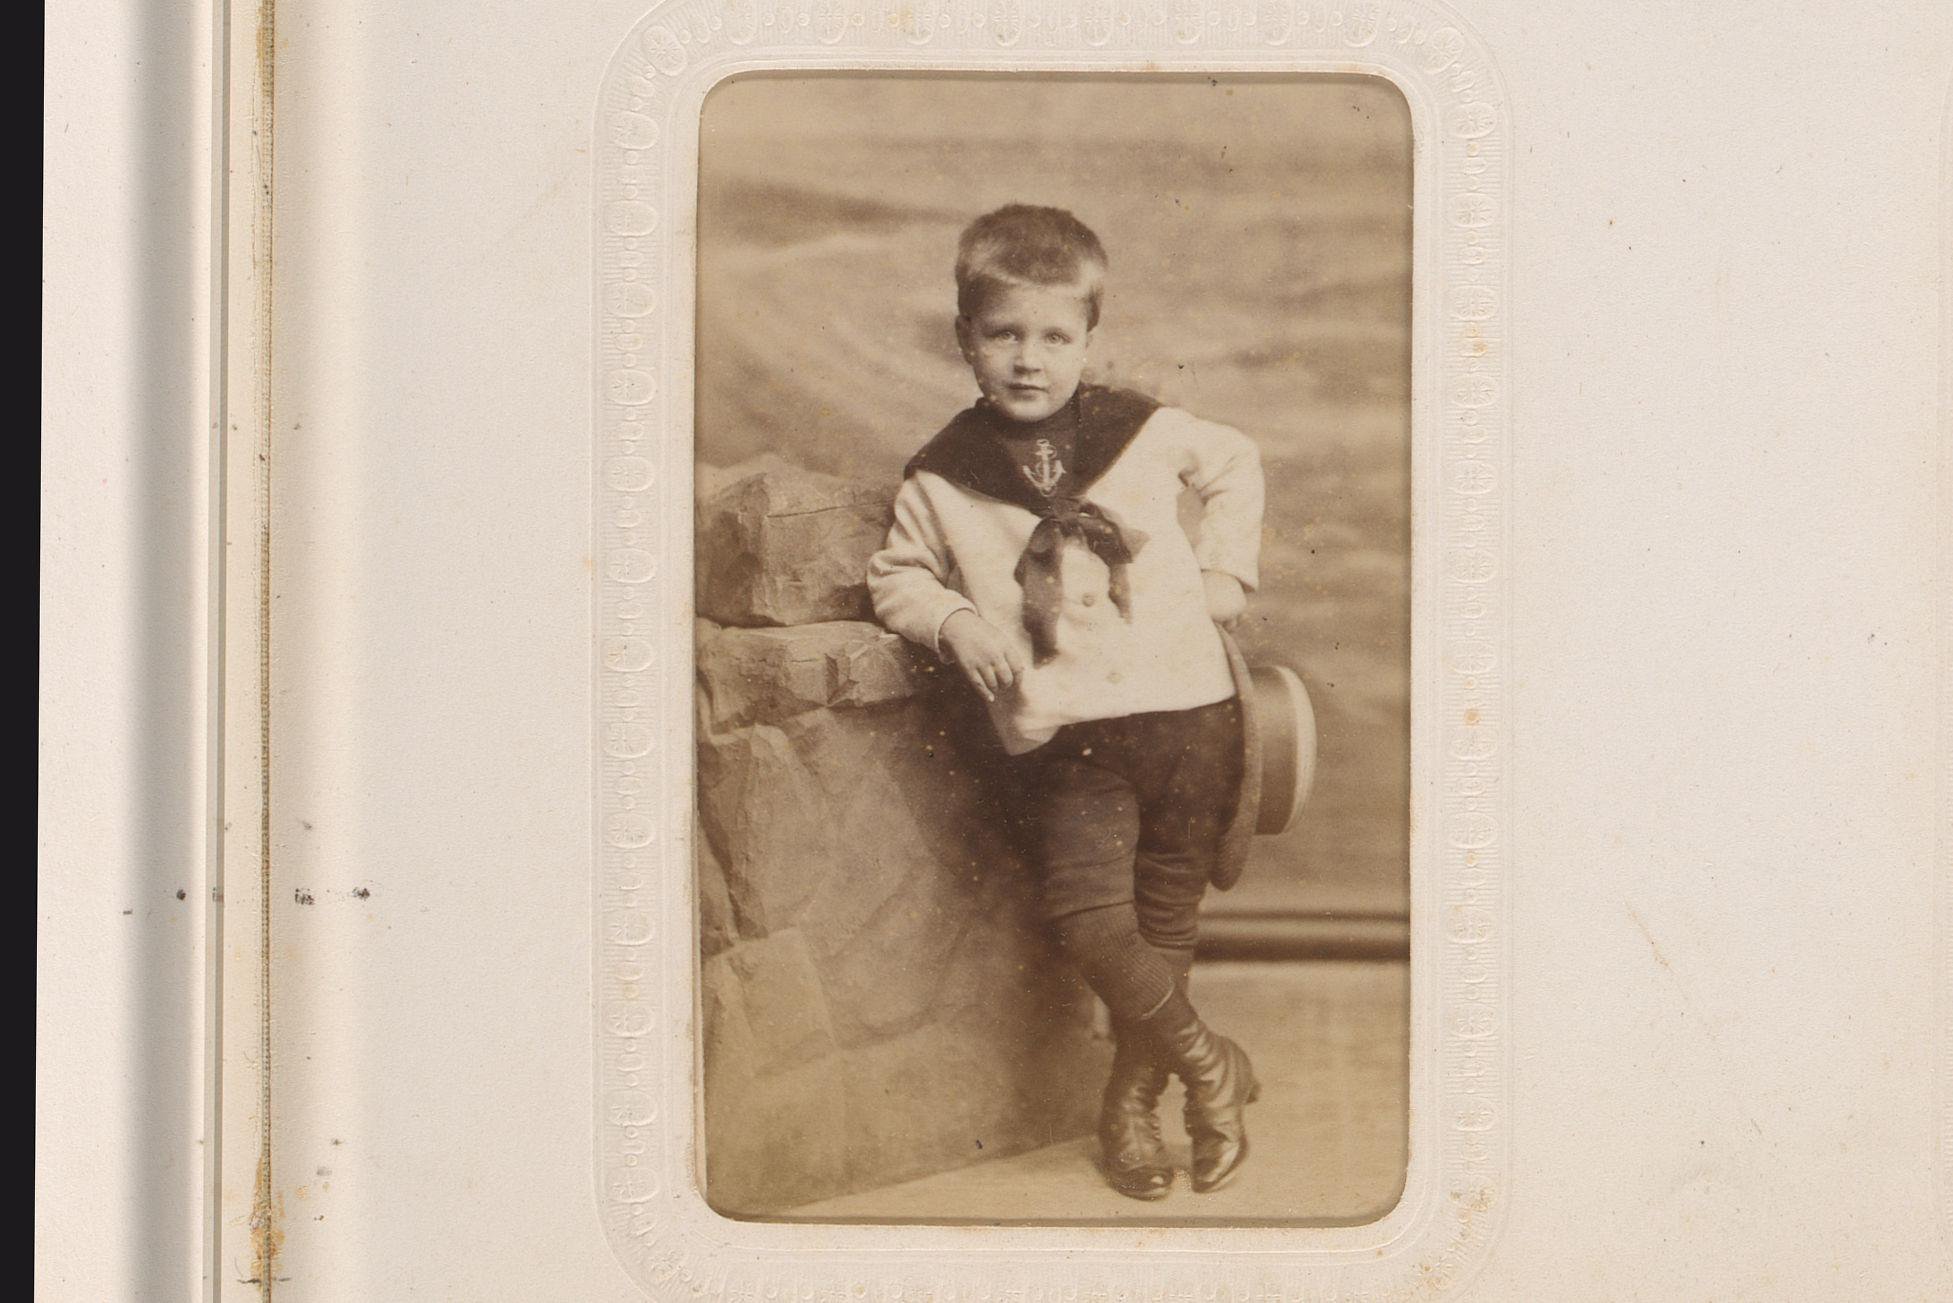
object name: photograph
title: Portret van twee kinderen op en naast een stoel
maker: Anonymous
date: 1860-1900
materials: cardboard, photographic support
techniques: albumen print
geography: netherlands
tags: tot, toddler ~ the ages of man (+ two persons), historical persons, chair